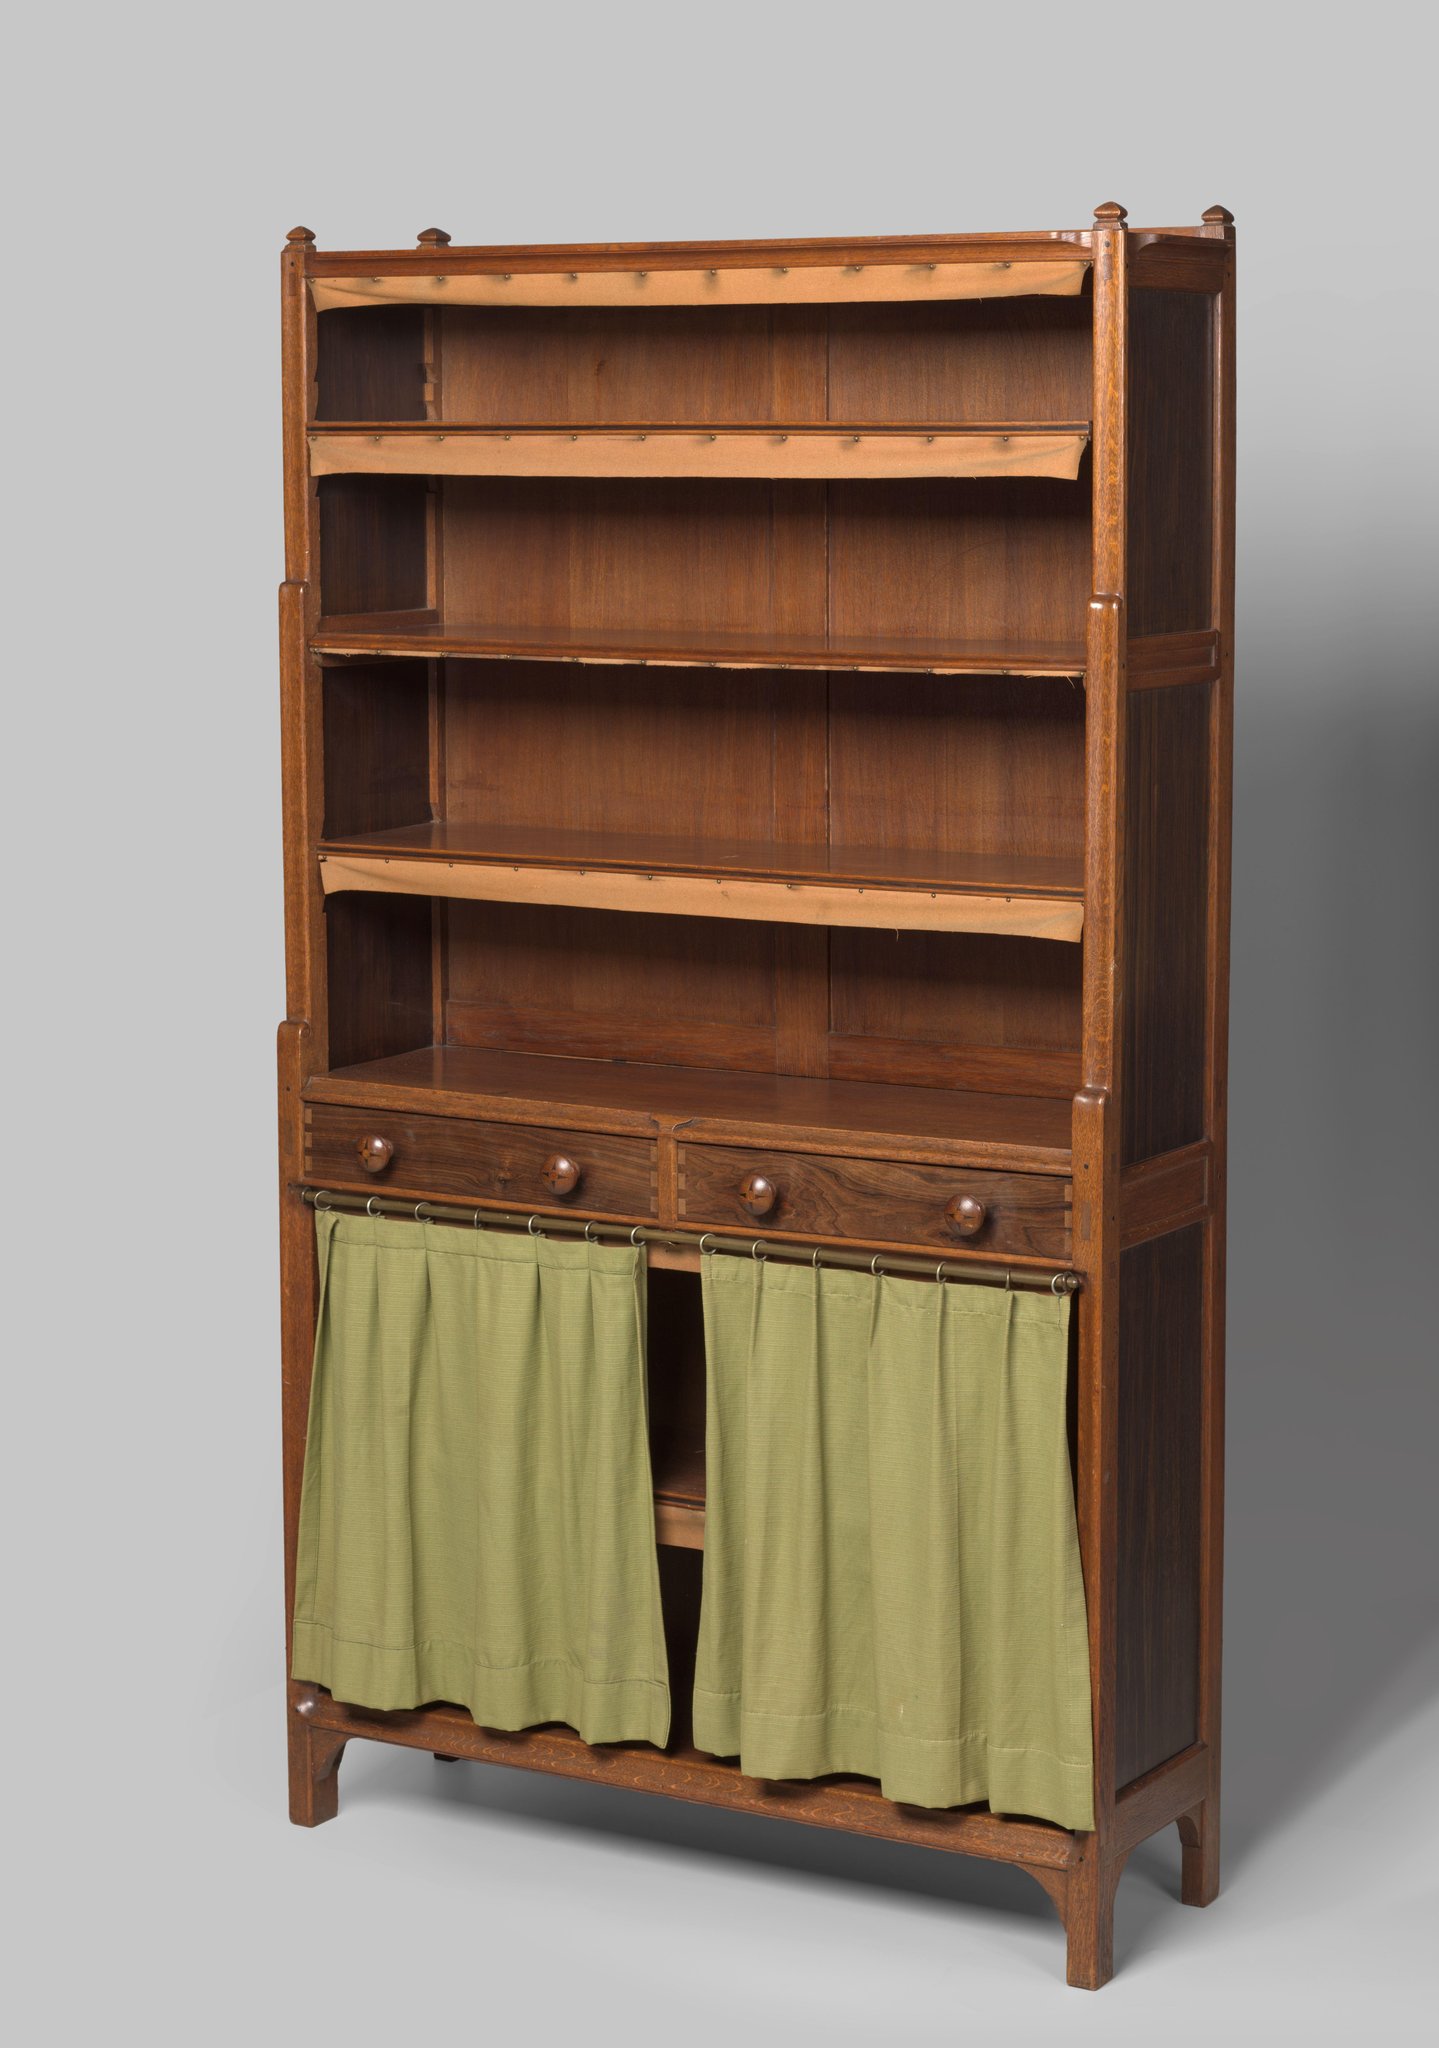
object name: bookcase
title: Boekenkast van eiken- en coromandelhout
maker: theo nieuwenhuis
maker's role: designer, draughtsman, print maker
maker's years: 1866-1951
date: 1915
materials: wood, textile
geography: amsterdam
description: Boekenkast van eiken- en coromandelhout. De kast bevat van onder naar boven een plank, twee laden met knoppen als trekkers en drie planken. Voor het ondergedeelte is een gordijn geplaatst.